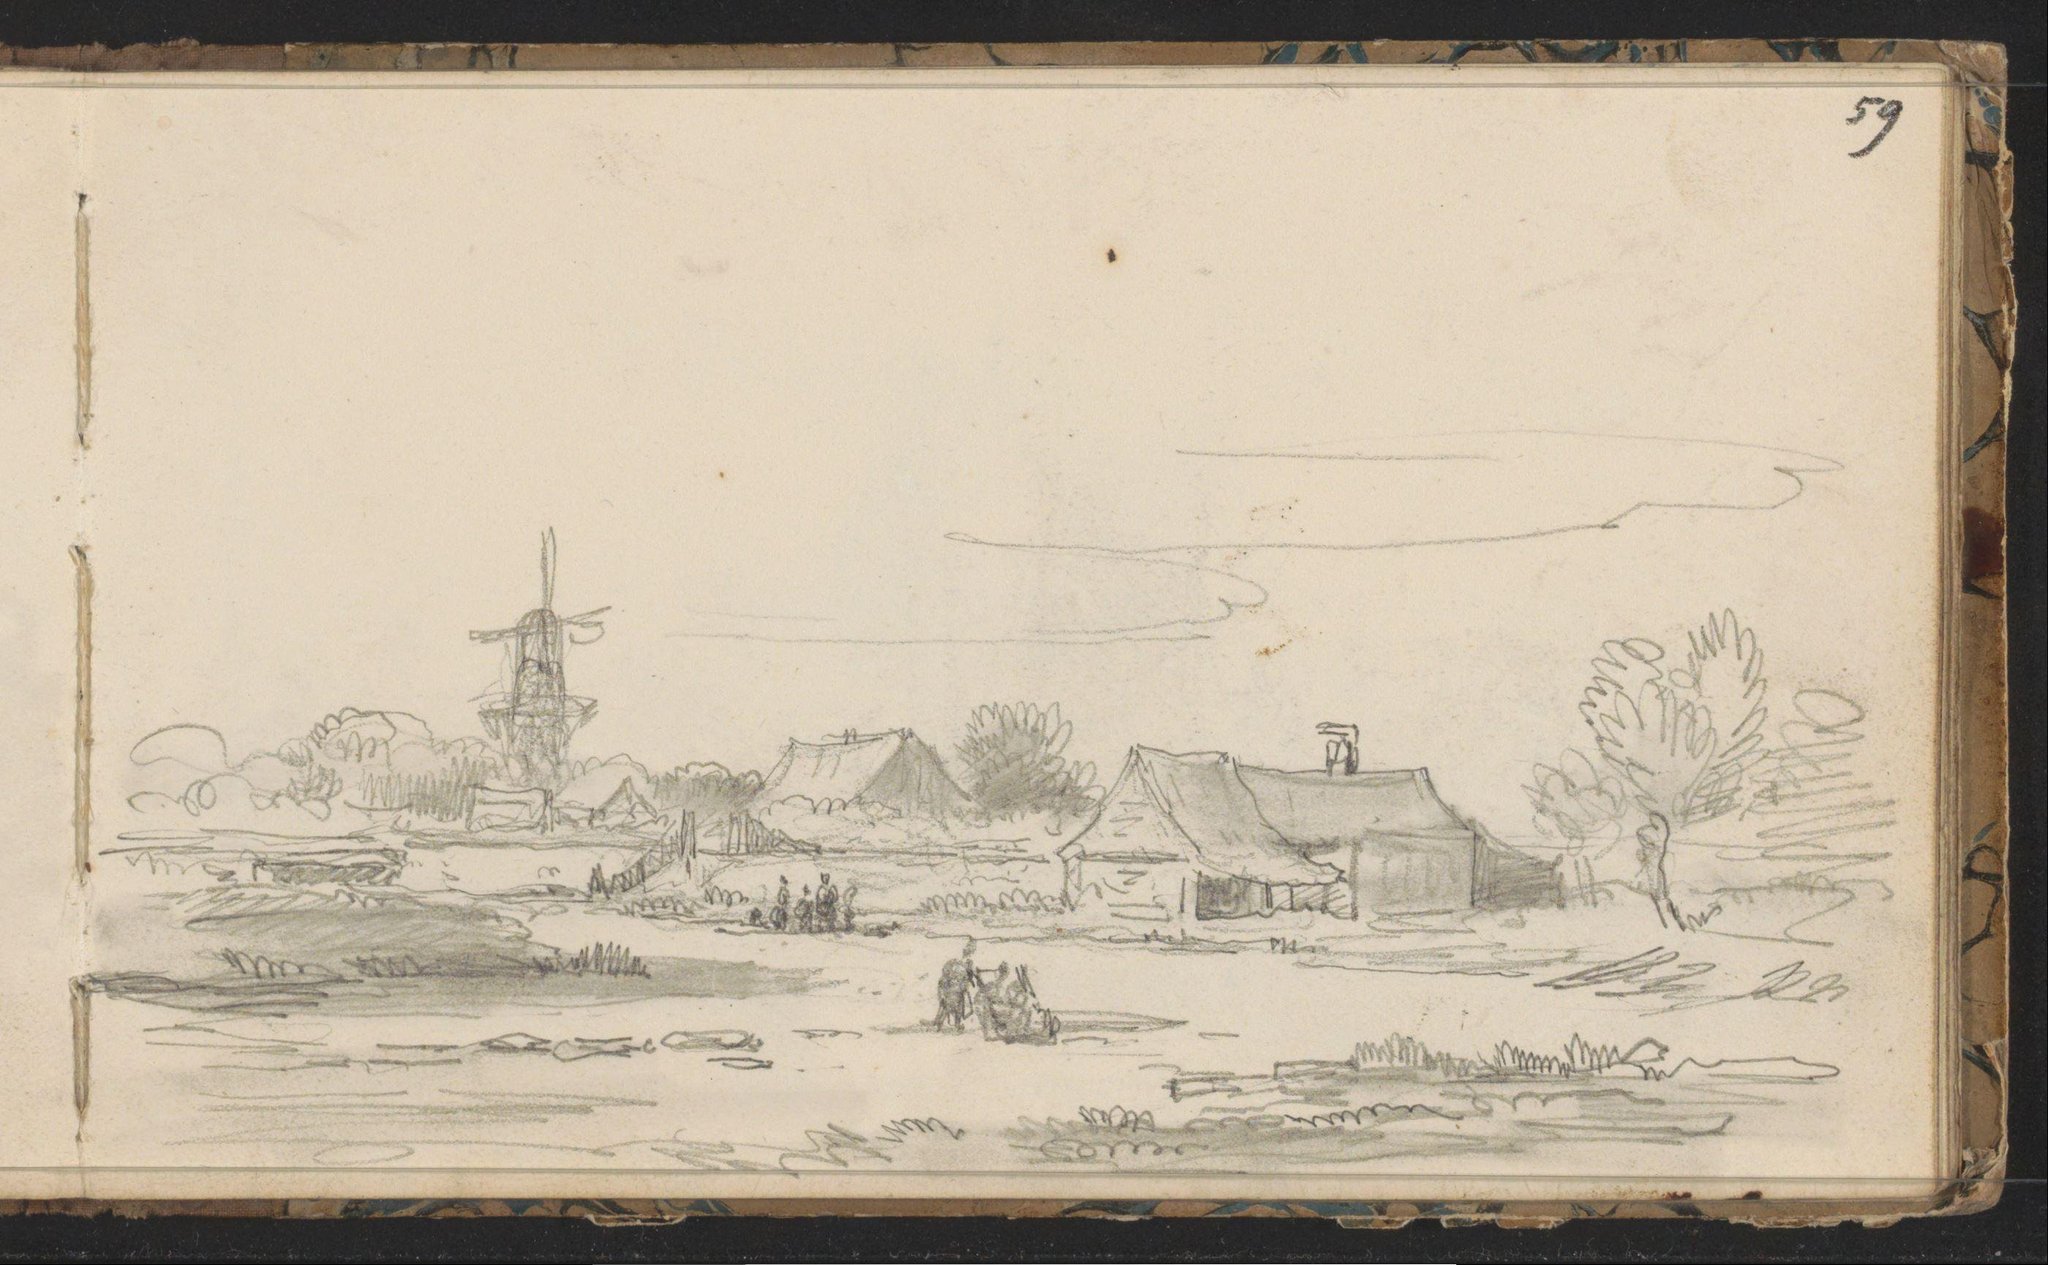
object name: sketchbook leaf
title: Landschap met boerderijen en een molen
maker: arnoldus johannes eymer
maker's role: draughtsman, print maker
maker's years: 1803-1863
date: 1803-1818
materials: paper, pencil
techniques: stumping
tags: windmill in landscape (+ city(-scape) with figures, staffage), farm (building)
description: Bladzijde 59 uit een schetsboek met 74 bladzijden.